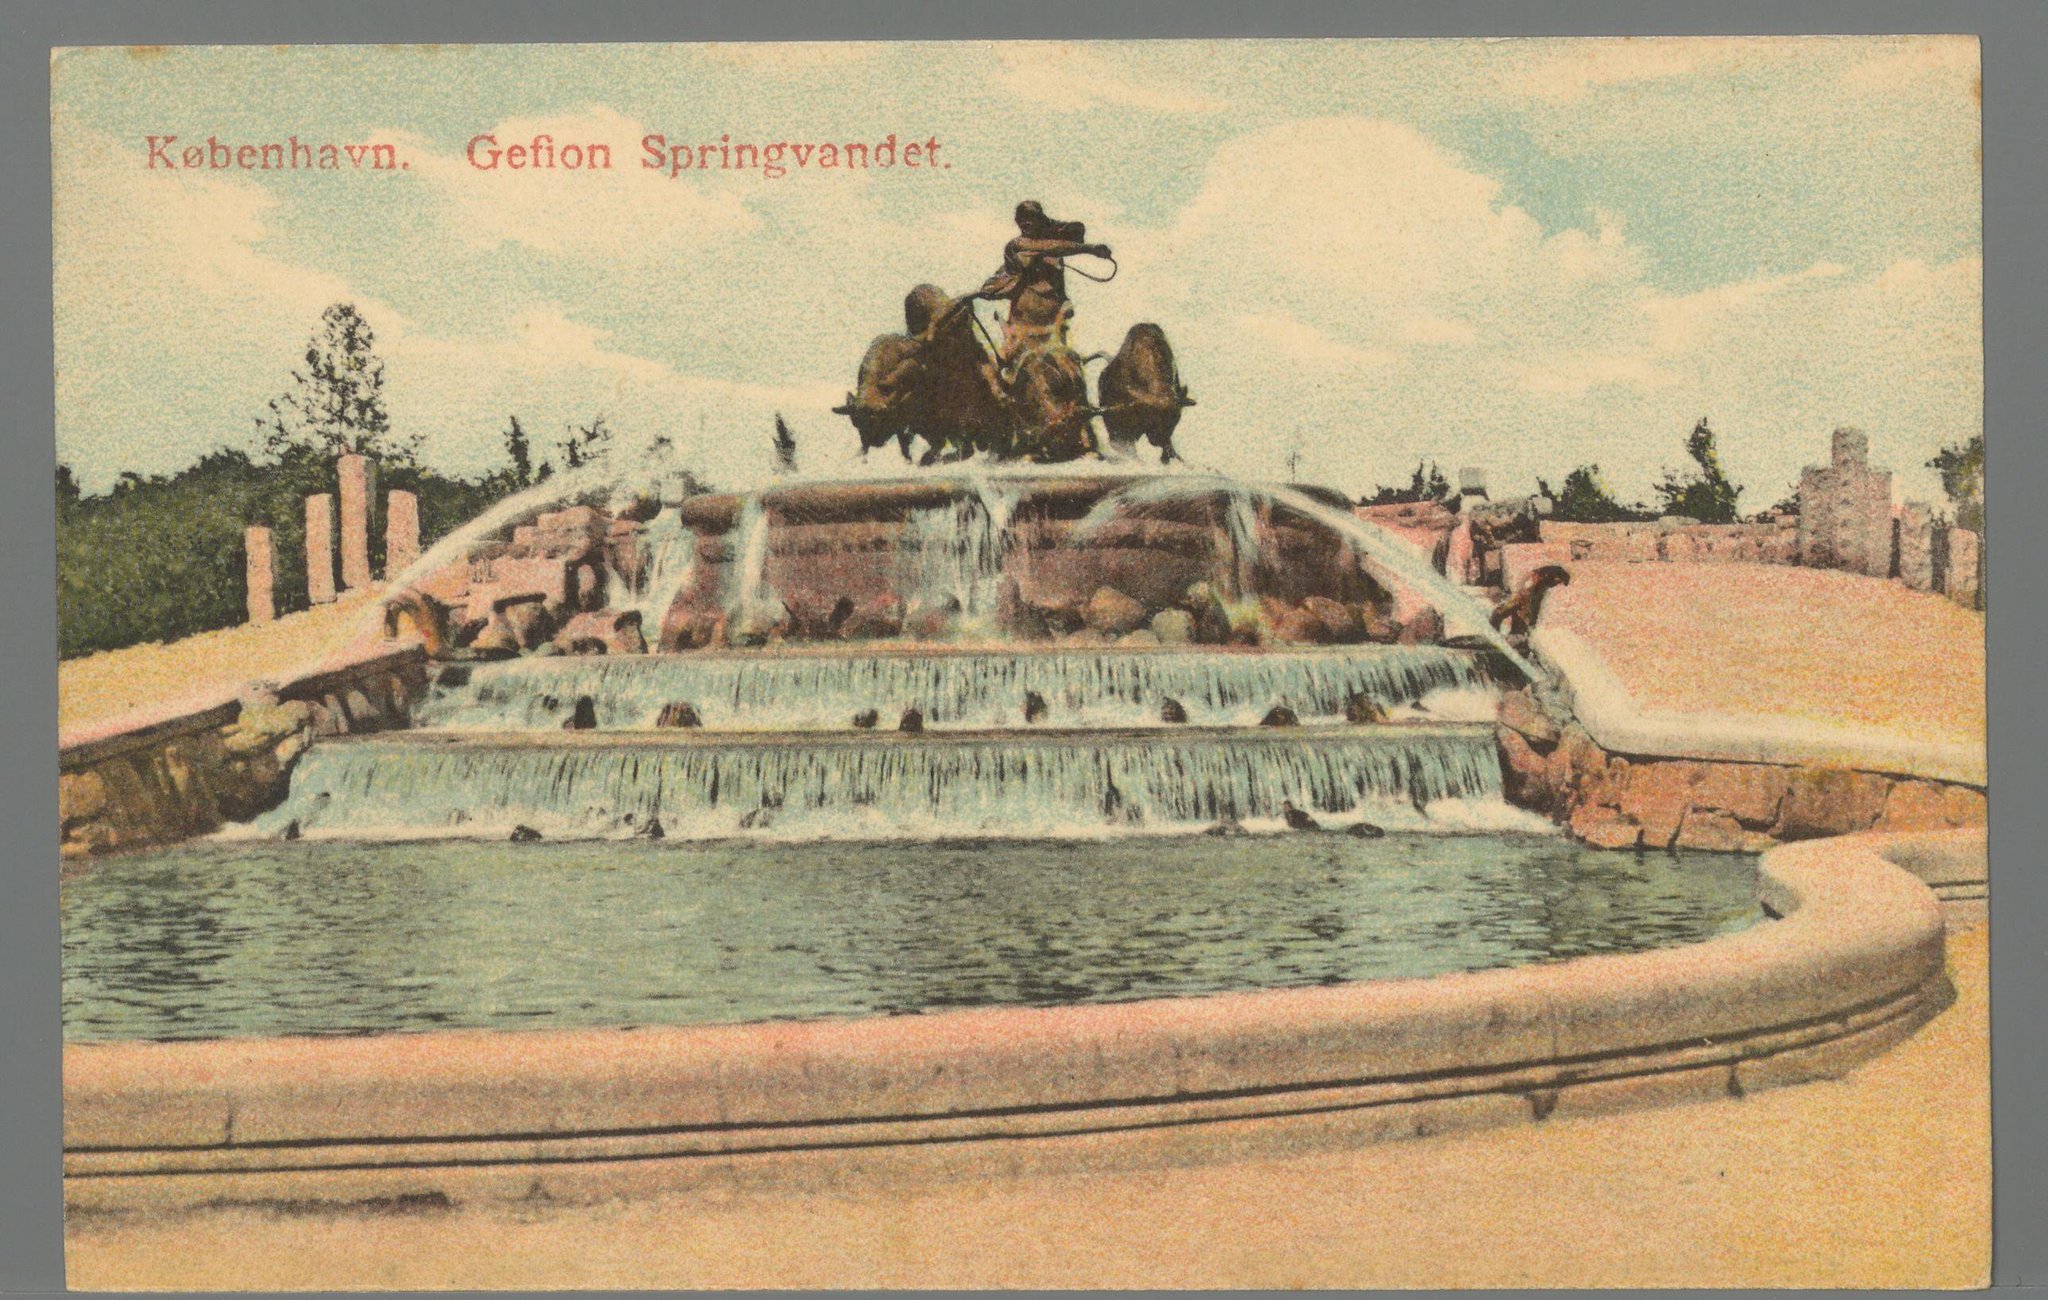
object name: photomechanical print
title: København. Gefion Springvandet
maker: Anonymous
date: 1906-1920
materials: cardboard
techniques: photograph, lithograph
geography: copenhagen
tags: ornamental fountain, public gardens, park, copenhagen (city)